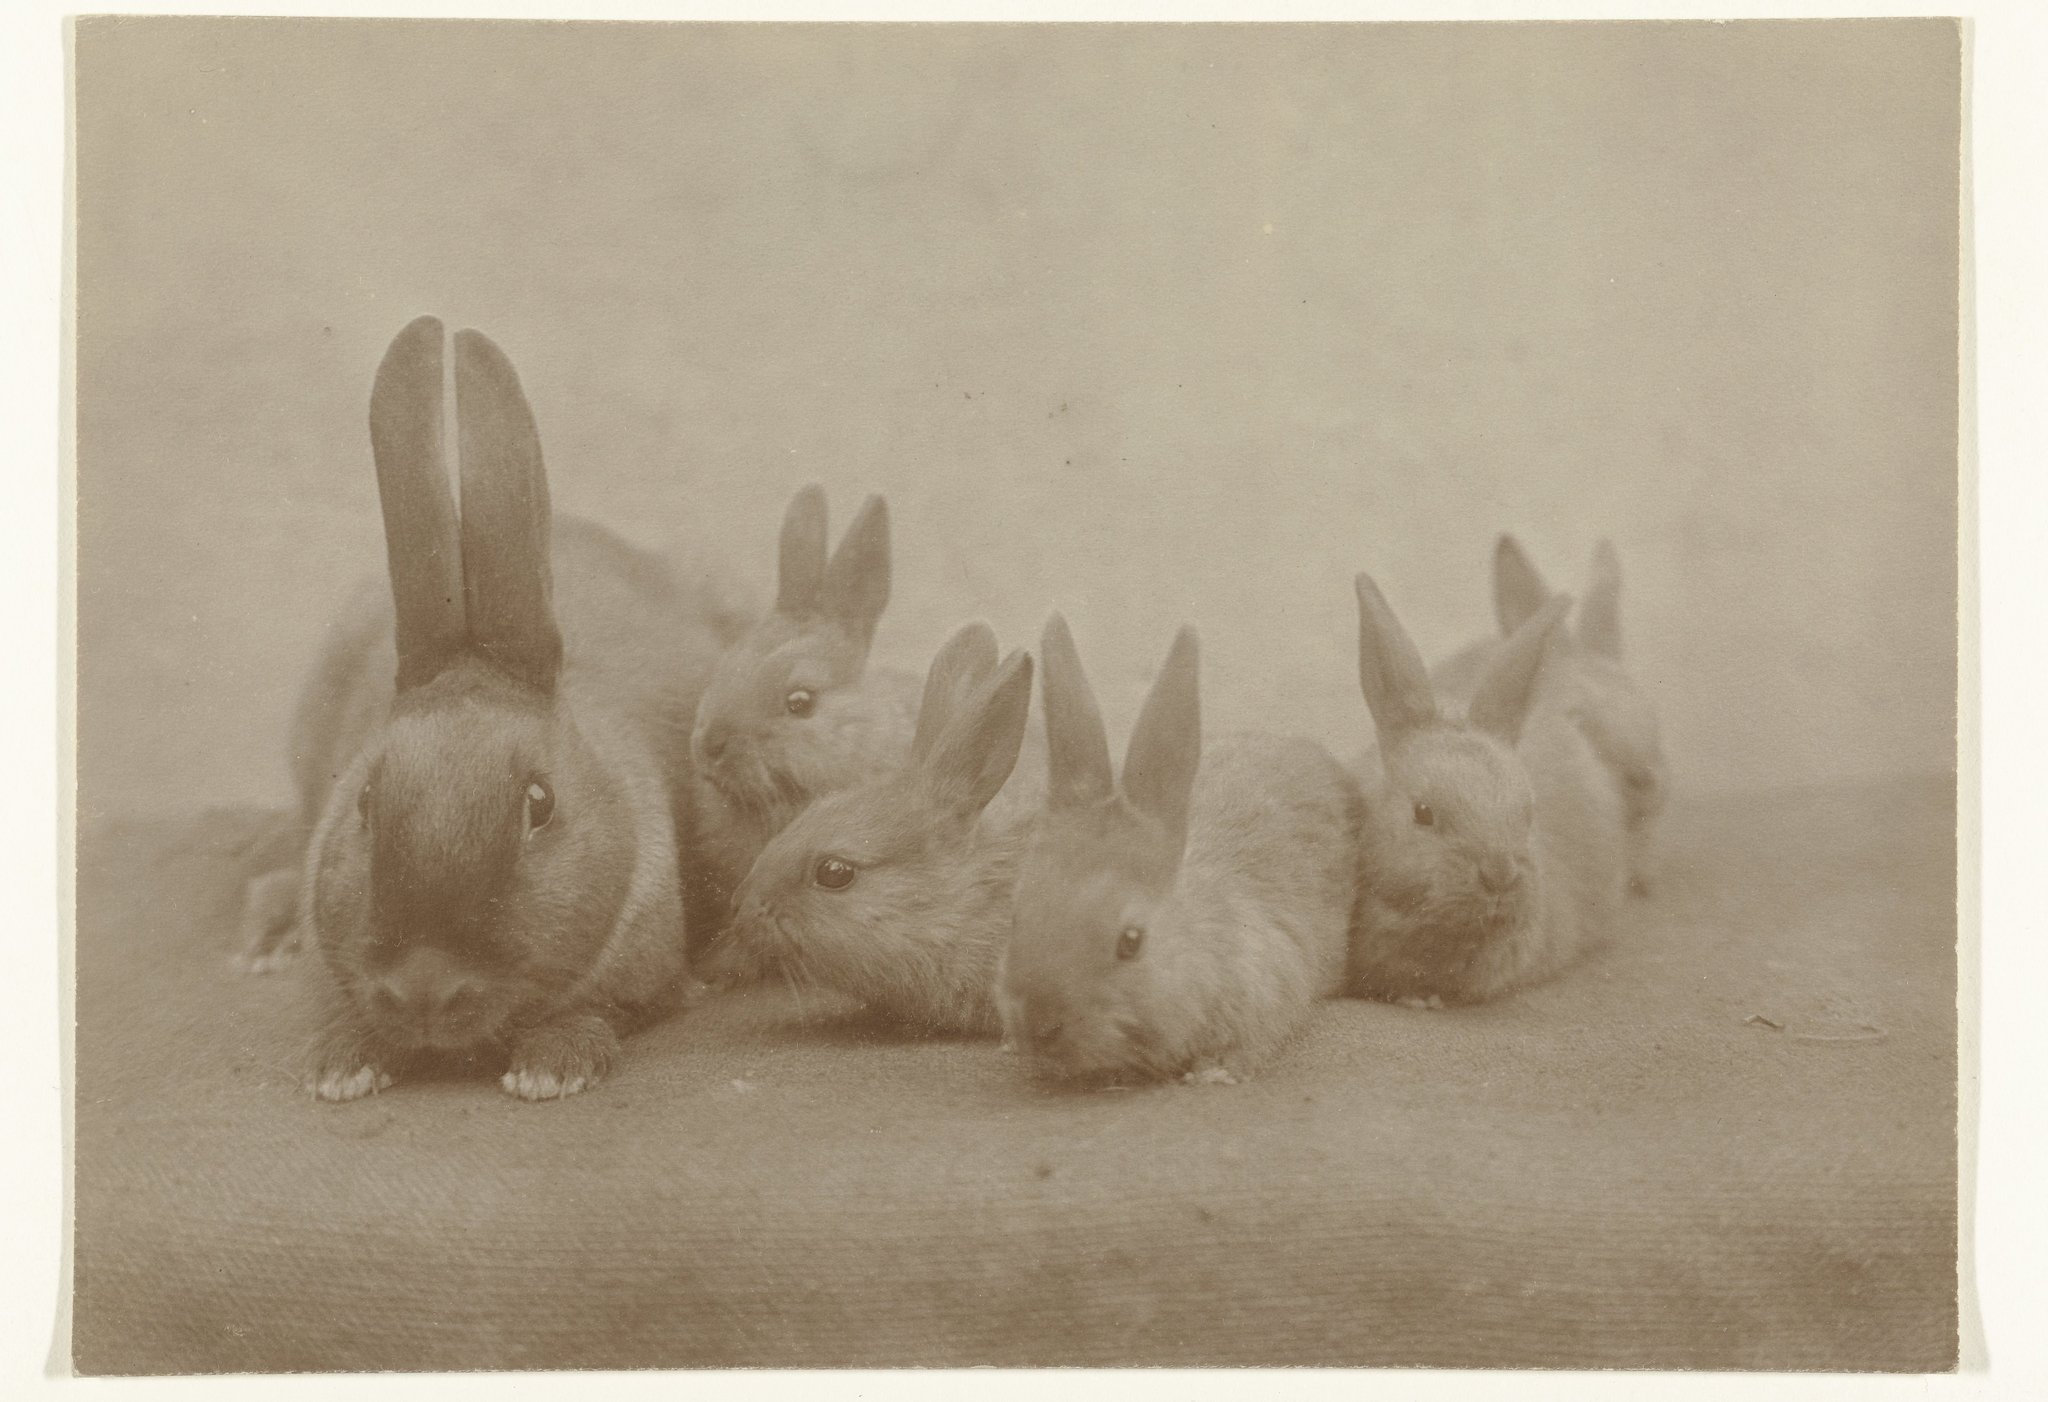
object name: photograph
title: Tiere I / (Junge Tiere) / Thuringerwoud Konijnen / Voedster met jongen / Thuringerwalder Kaninchen / Häsin mit jungen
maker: richard tepe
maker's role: fotograaf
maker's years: 1864-1952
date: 1900-1930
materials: paper, photographic support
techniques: gelatin silver print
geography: netherlands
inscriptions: signature: ‘foto / R Tepe’, annotation: ‘Tiere I / (Junge Tiere) / Thuringerwoud Konijnen / Voedster met jongen / Thuringerwalder Kaninchen / Häsin mit jungen’